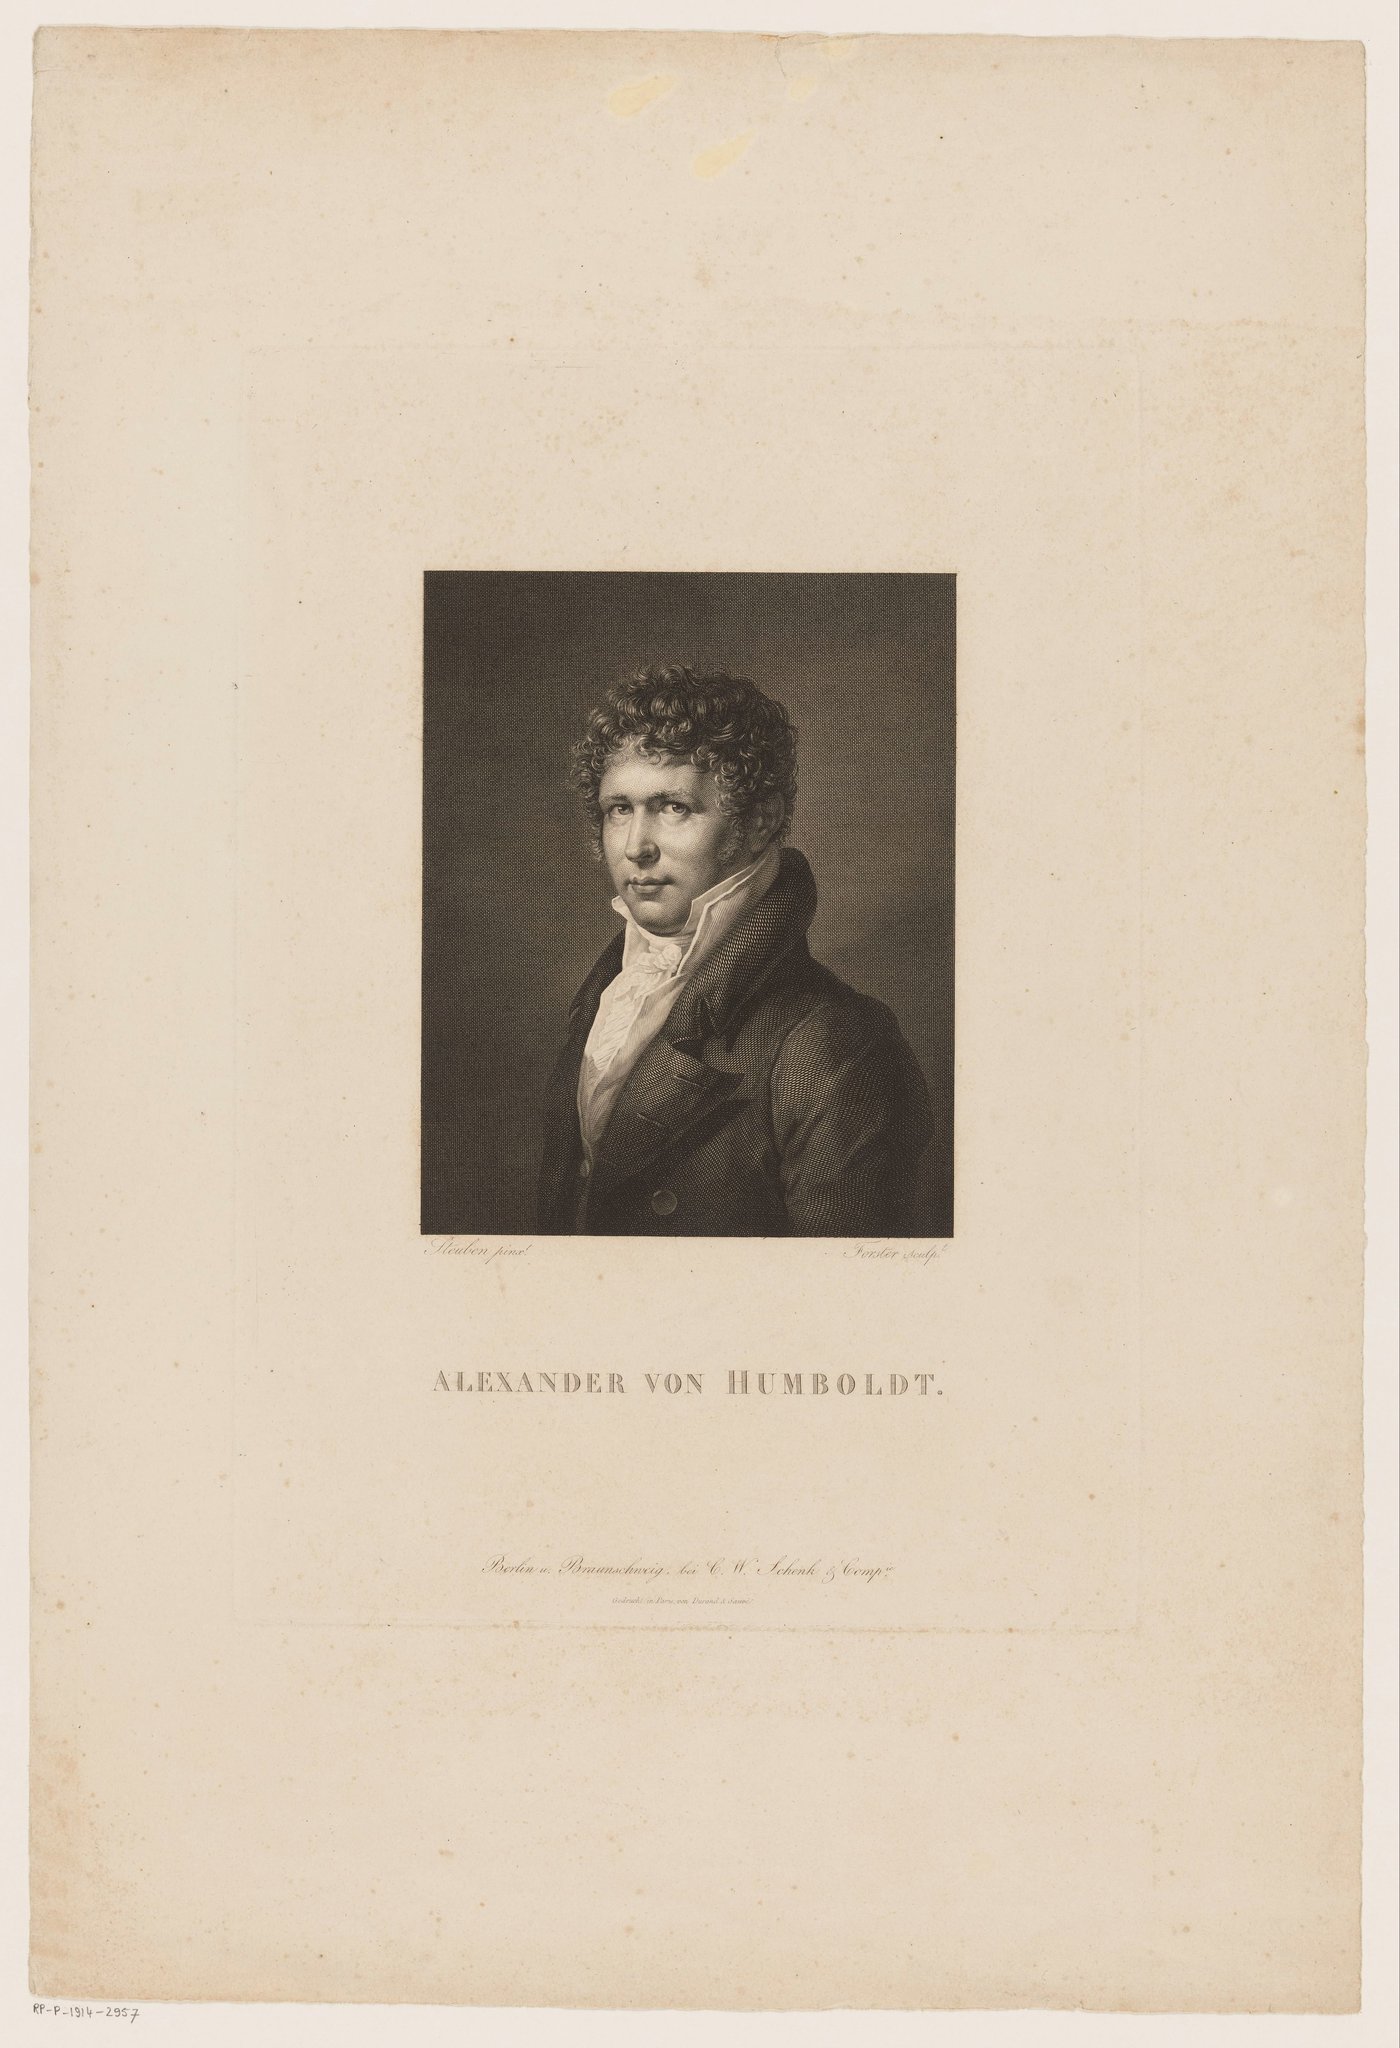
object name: print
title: Portret van Alexander von Humboldt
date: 1800-1831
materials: paper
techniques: engraving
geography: paris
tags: scholar, philosopher, historical persons, explorer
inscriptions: collector's mark: Lugt 2228